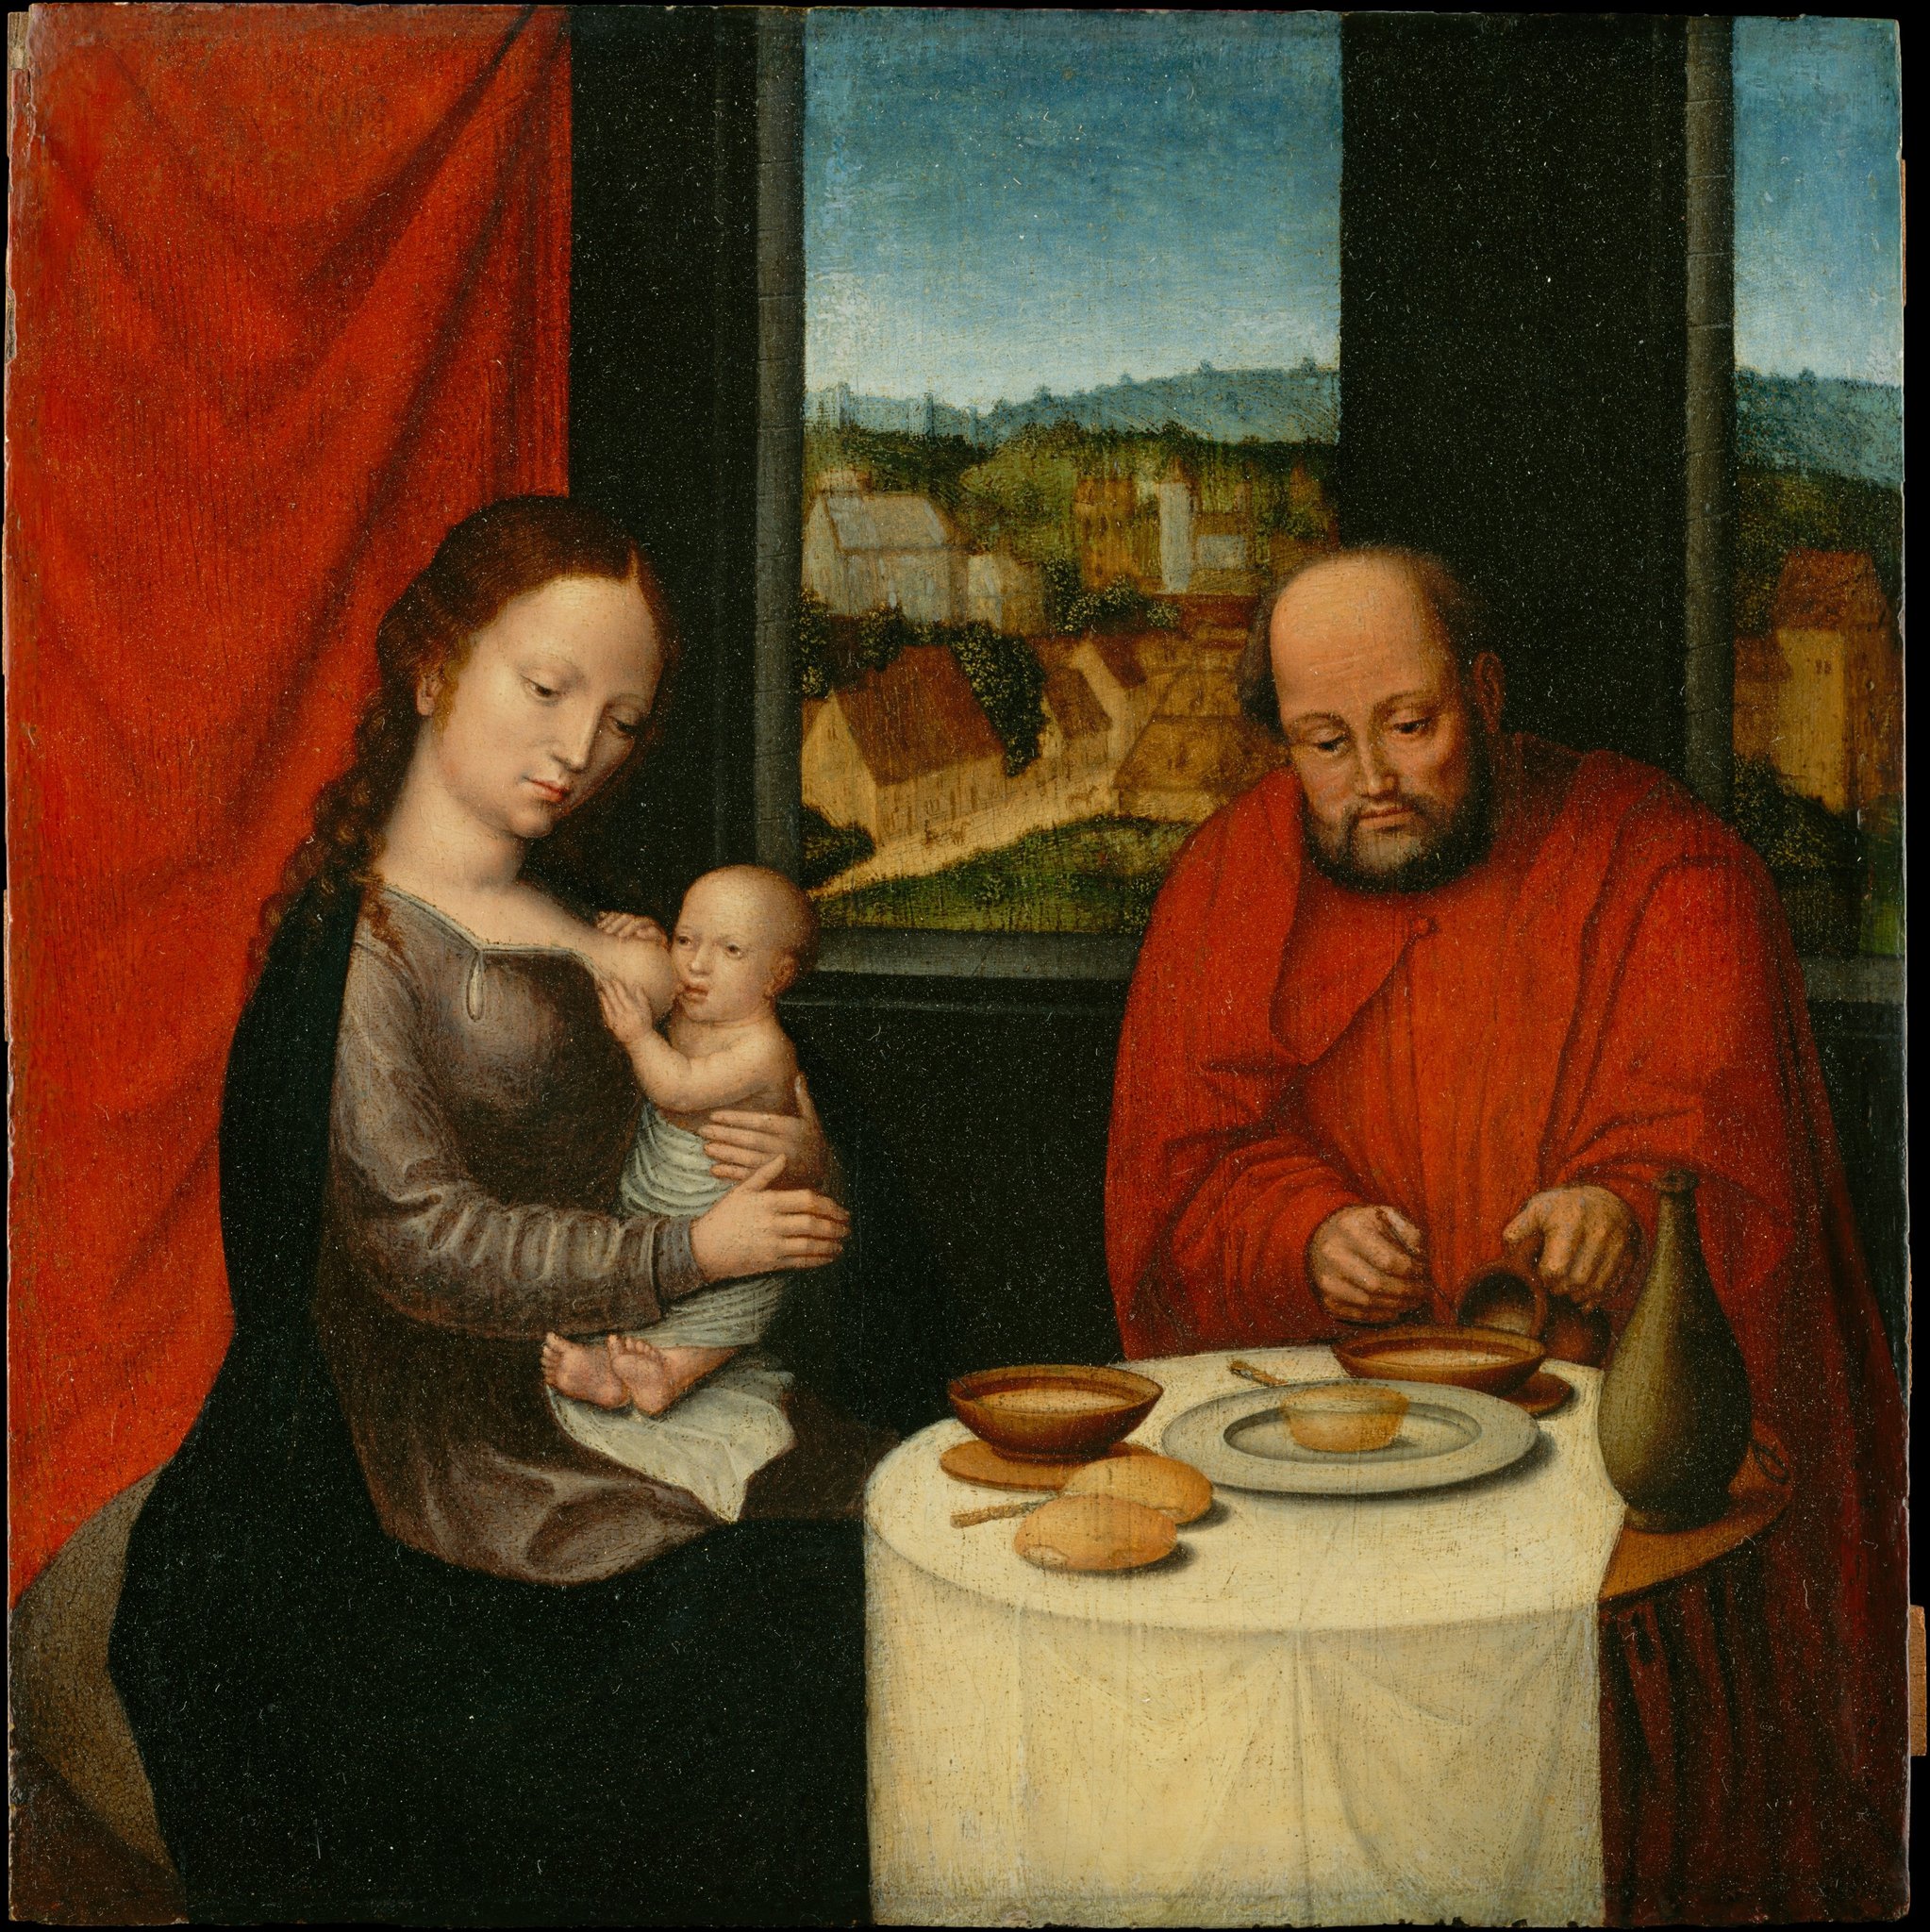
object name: painting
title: Virgin and Child with Saint Joseph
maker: netherlandish painter, second half of 16th century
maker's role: artist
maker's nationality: netherlandish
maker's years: 1550-1599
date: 1551-1600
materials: wood, oil, panel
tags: bread,madonna and child,saint joseph,dining